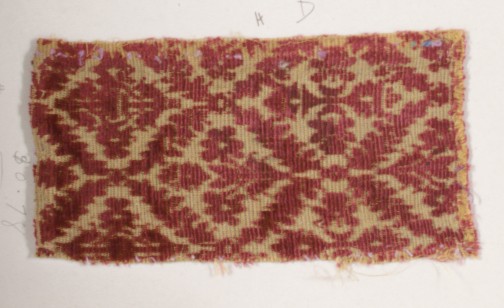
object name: fragment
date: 1701-1800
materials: metal thread, silk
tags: flowers